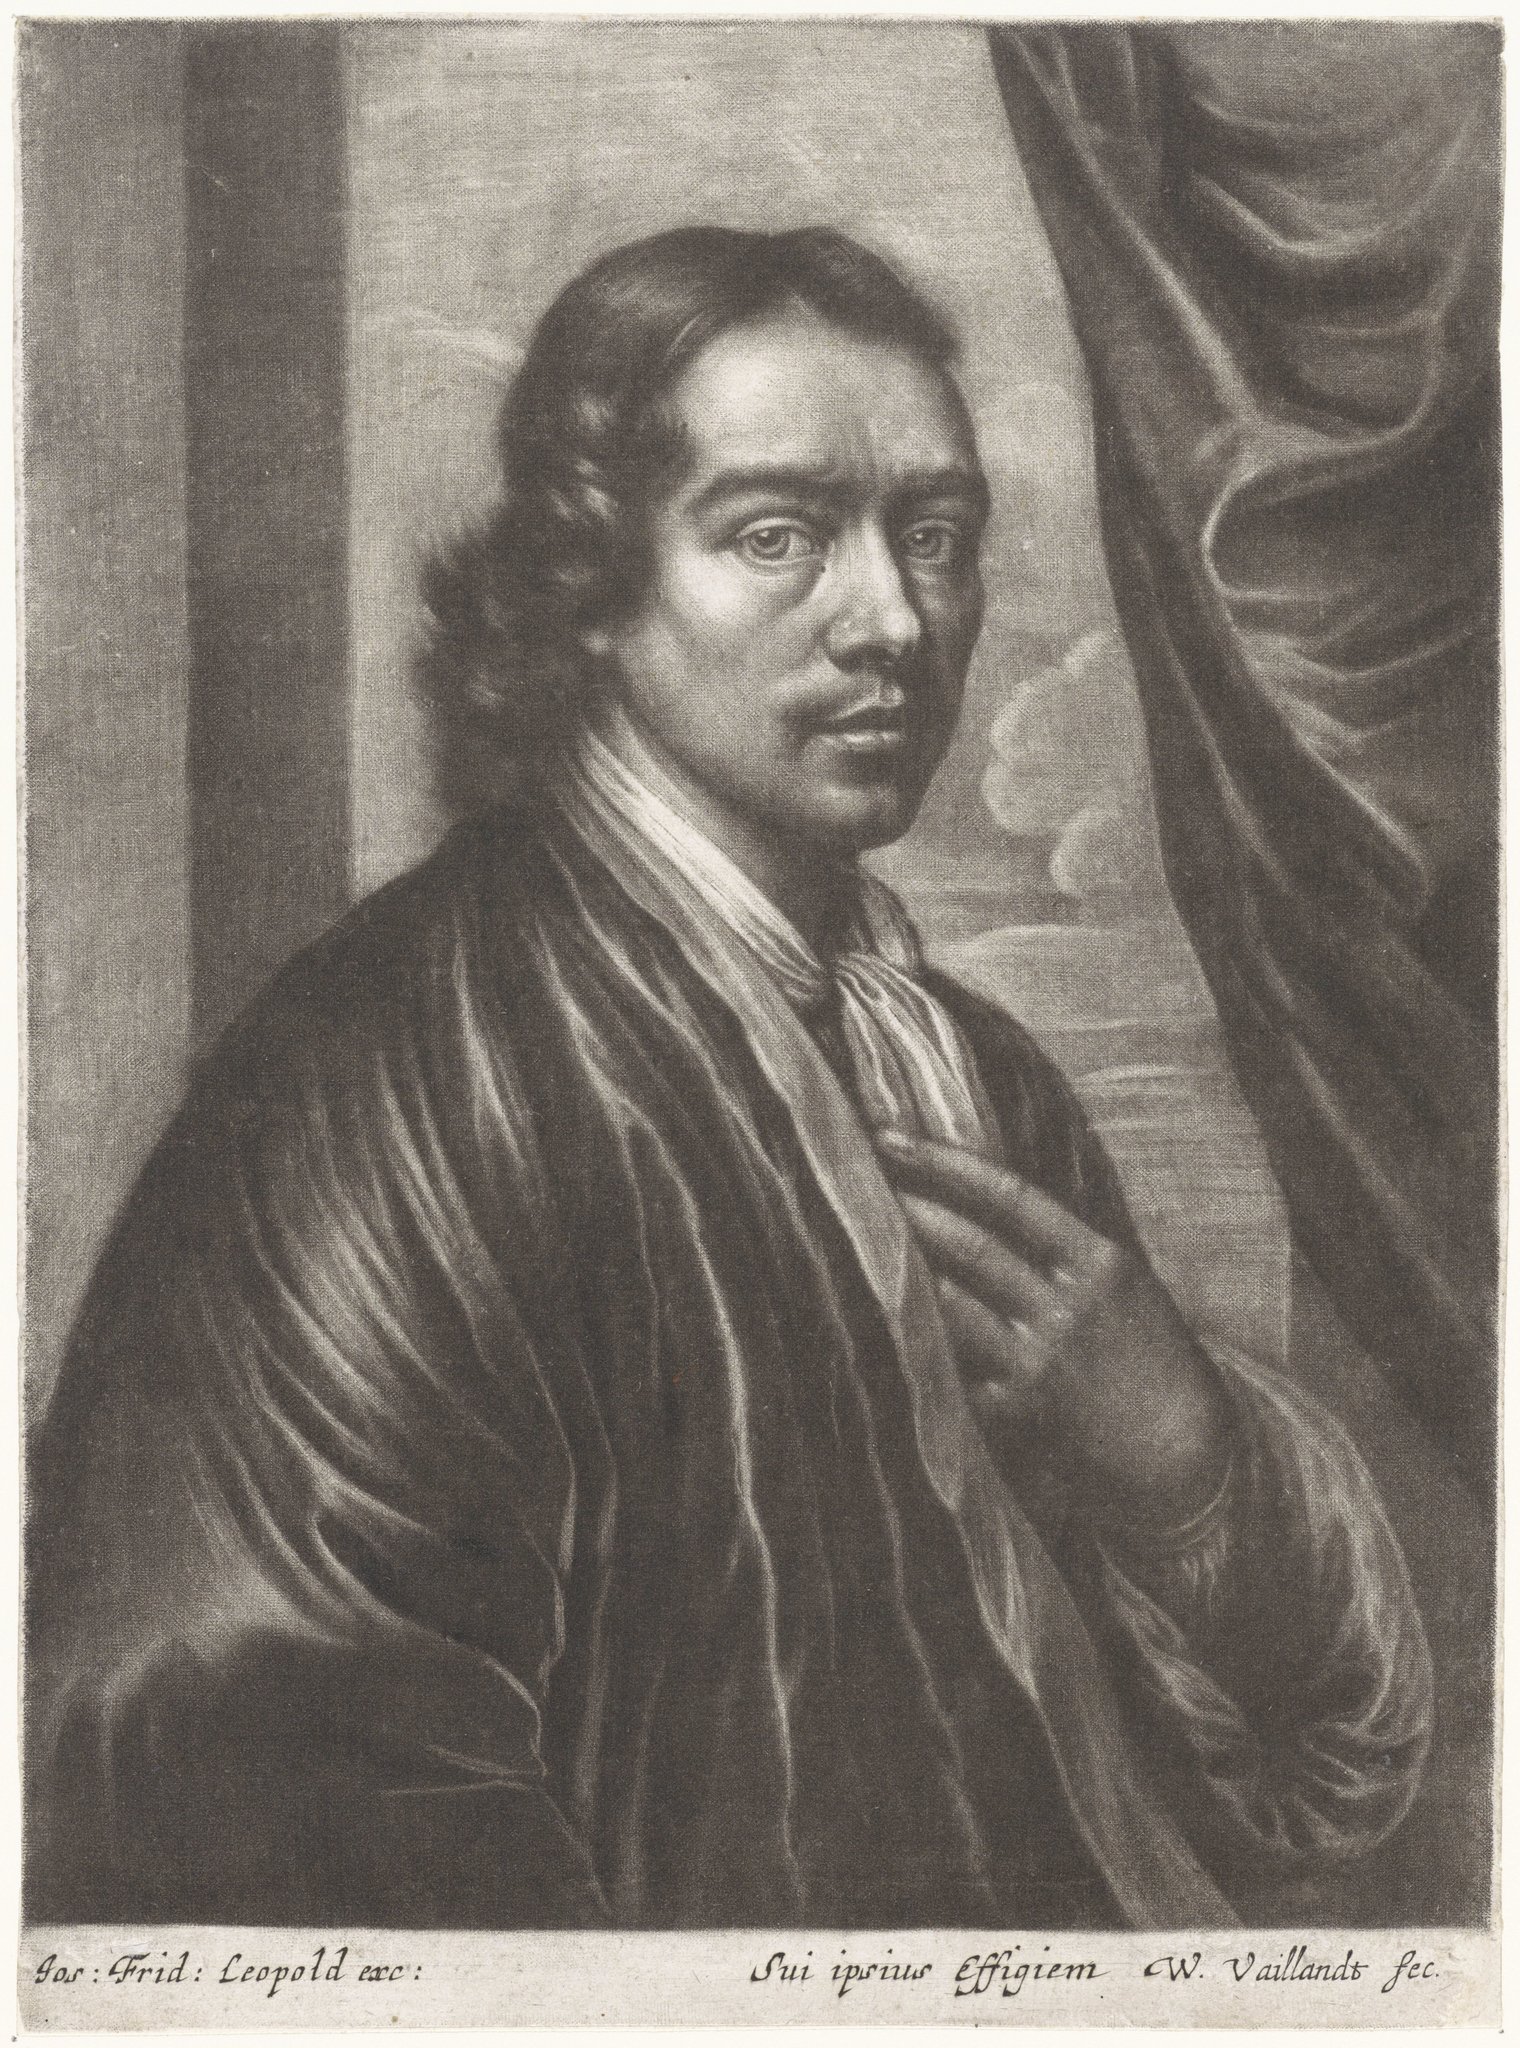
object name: print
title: Zelfportret van Wallerant Vaillant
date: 1678-1726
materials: paper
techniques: mezzotint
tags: lille, amsterdam, painter, print maker, wallerant vaillant, portrait, self-portrait of painter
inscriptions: collector's mark: Lugt 2228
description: De schilder, tekenaar en prentmaker Wallerant Vaillant staat voor een venster met een gordijn. Op de achtergrond een wolkenlucht.